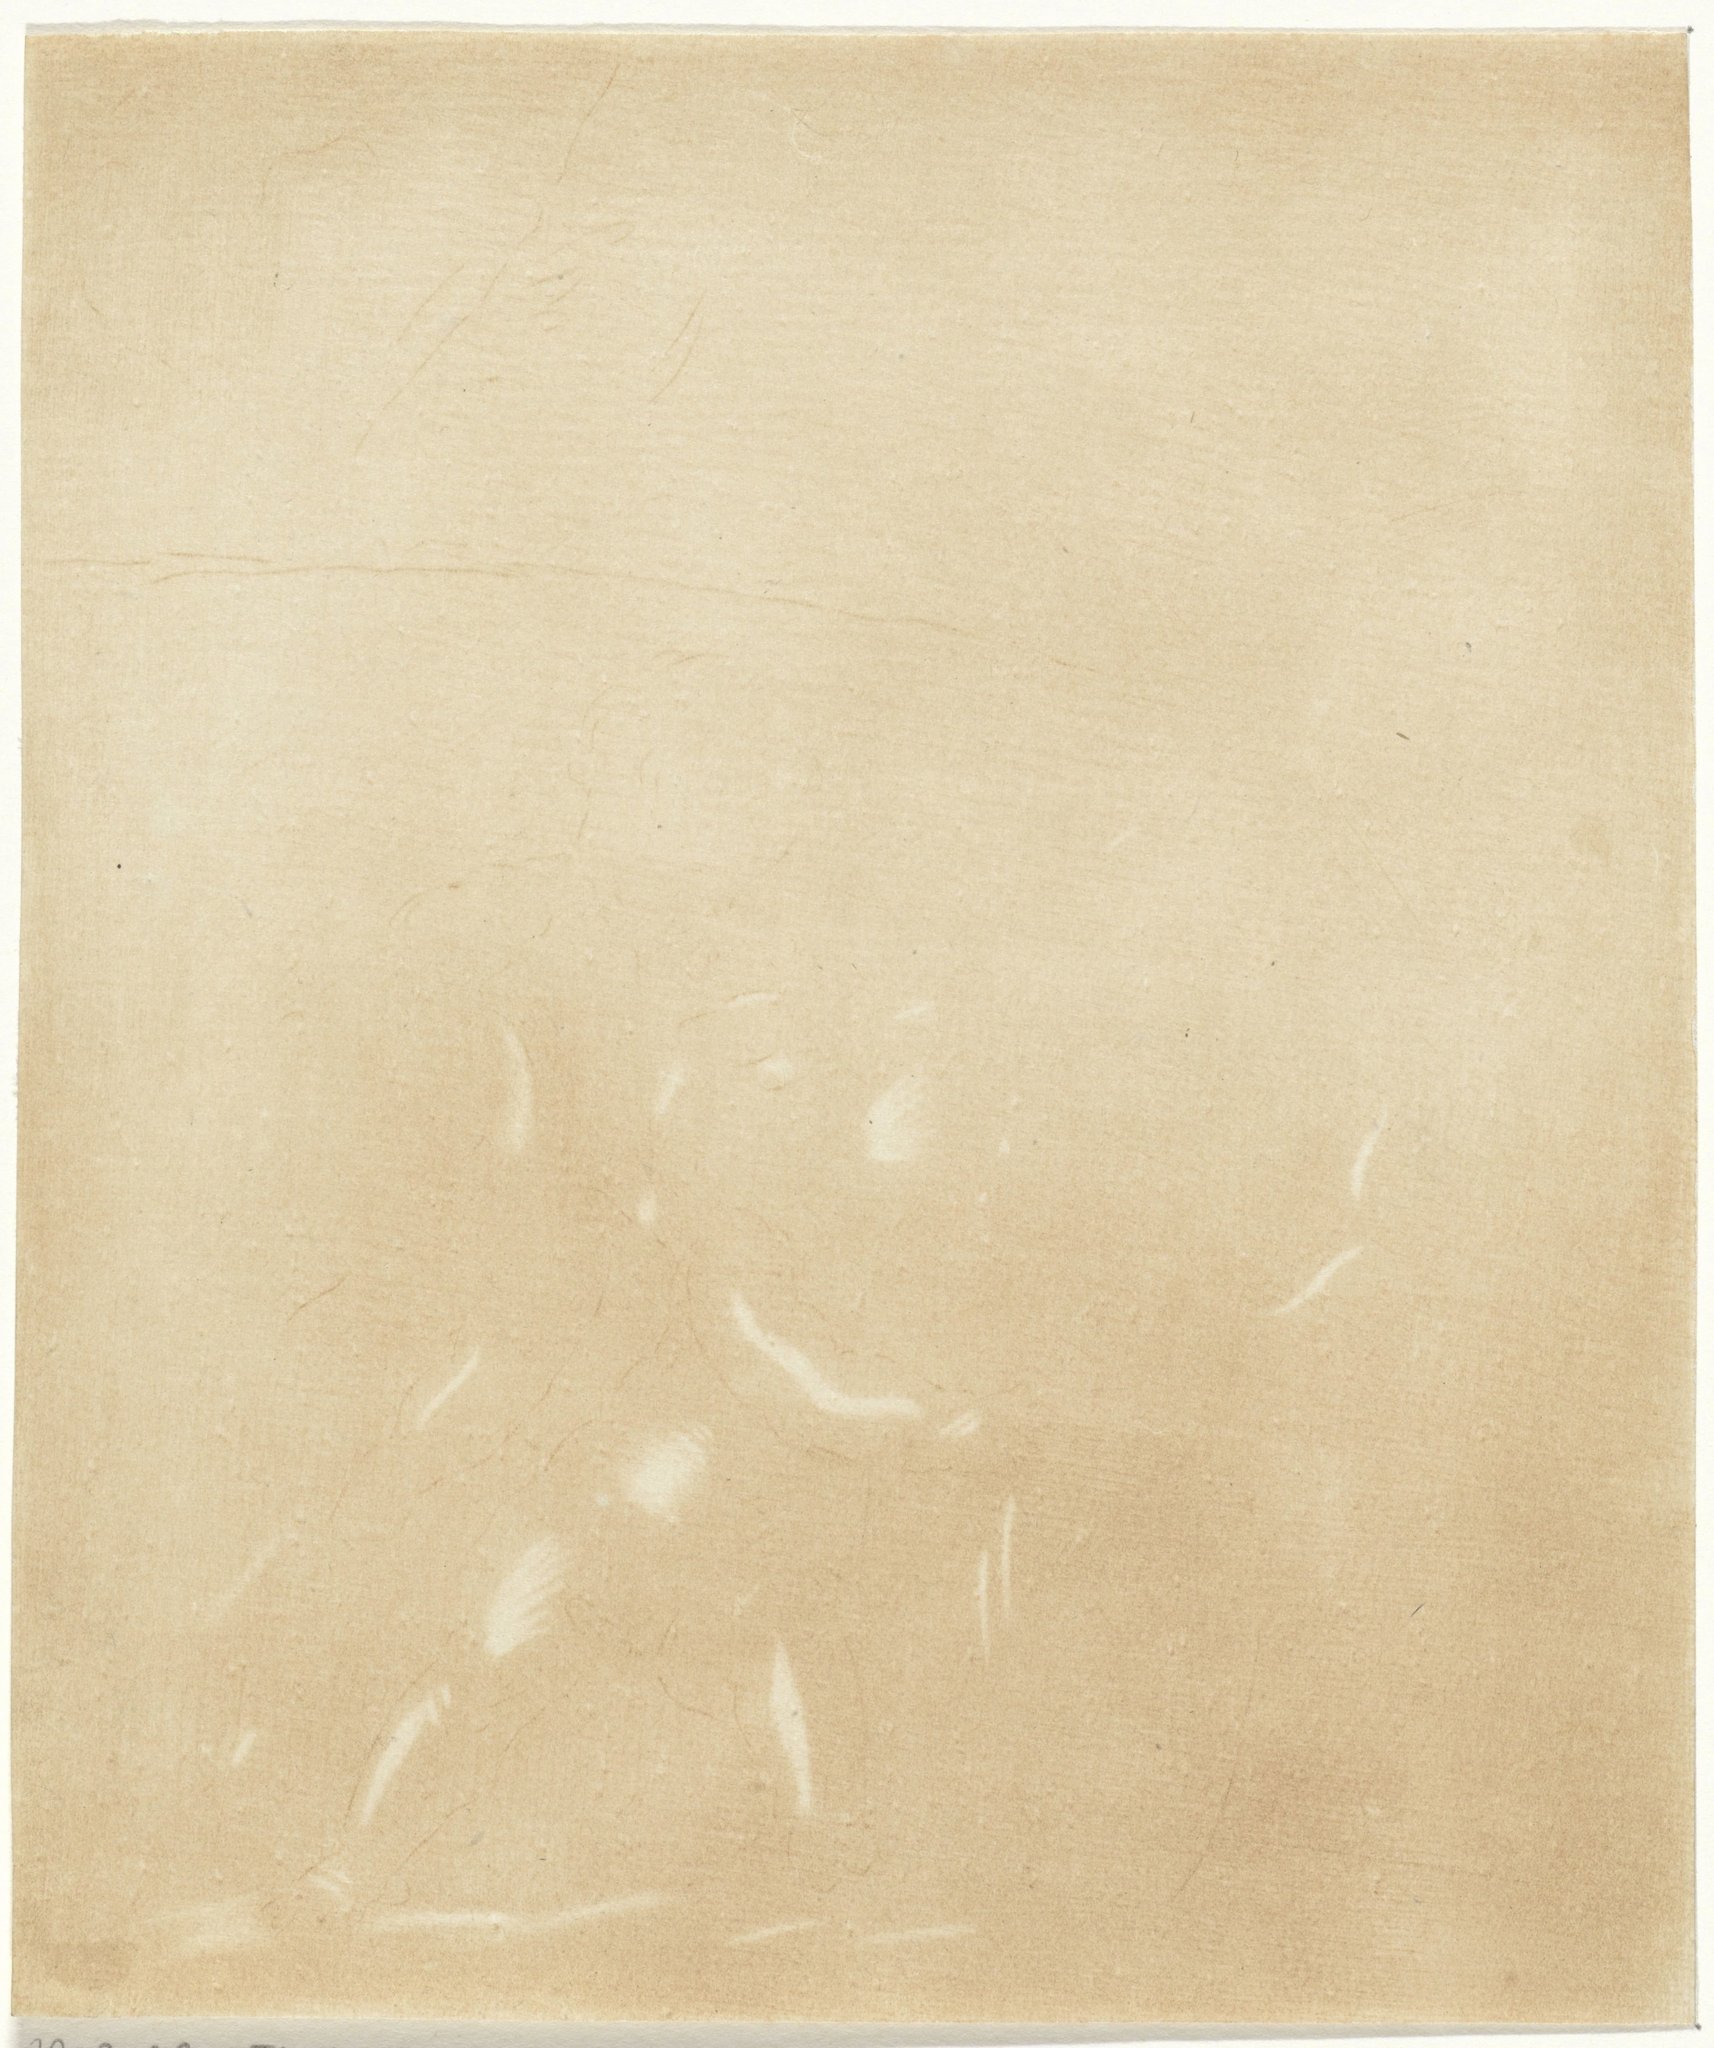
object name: print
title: Vier putti bij een vaas (achtergrond en hoogsels)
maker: bernhard schreuder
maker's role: print maker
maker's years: -1780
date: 1767-1780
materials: paper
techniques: printing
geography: netherlands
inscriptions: collector's mark: Lugt 2228